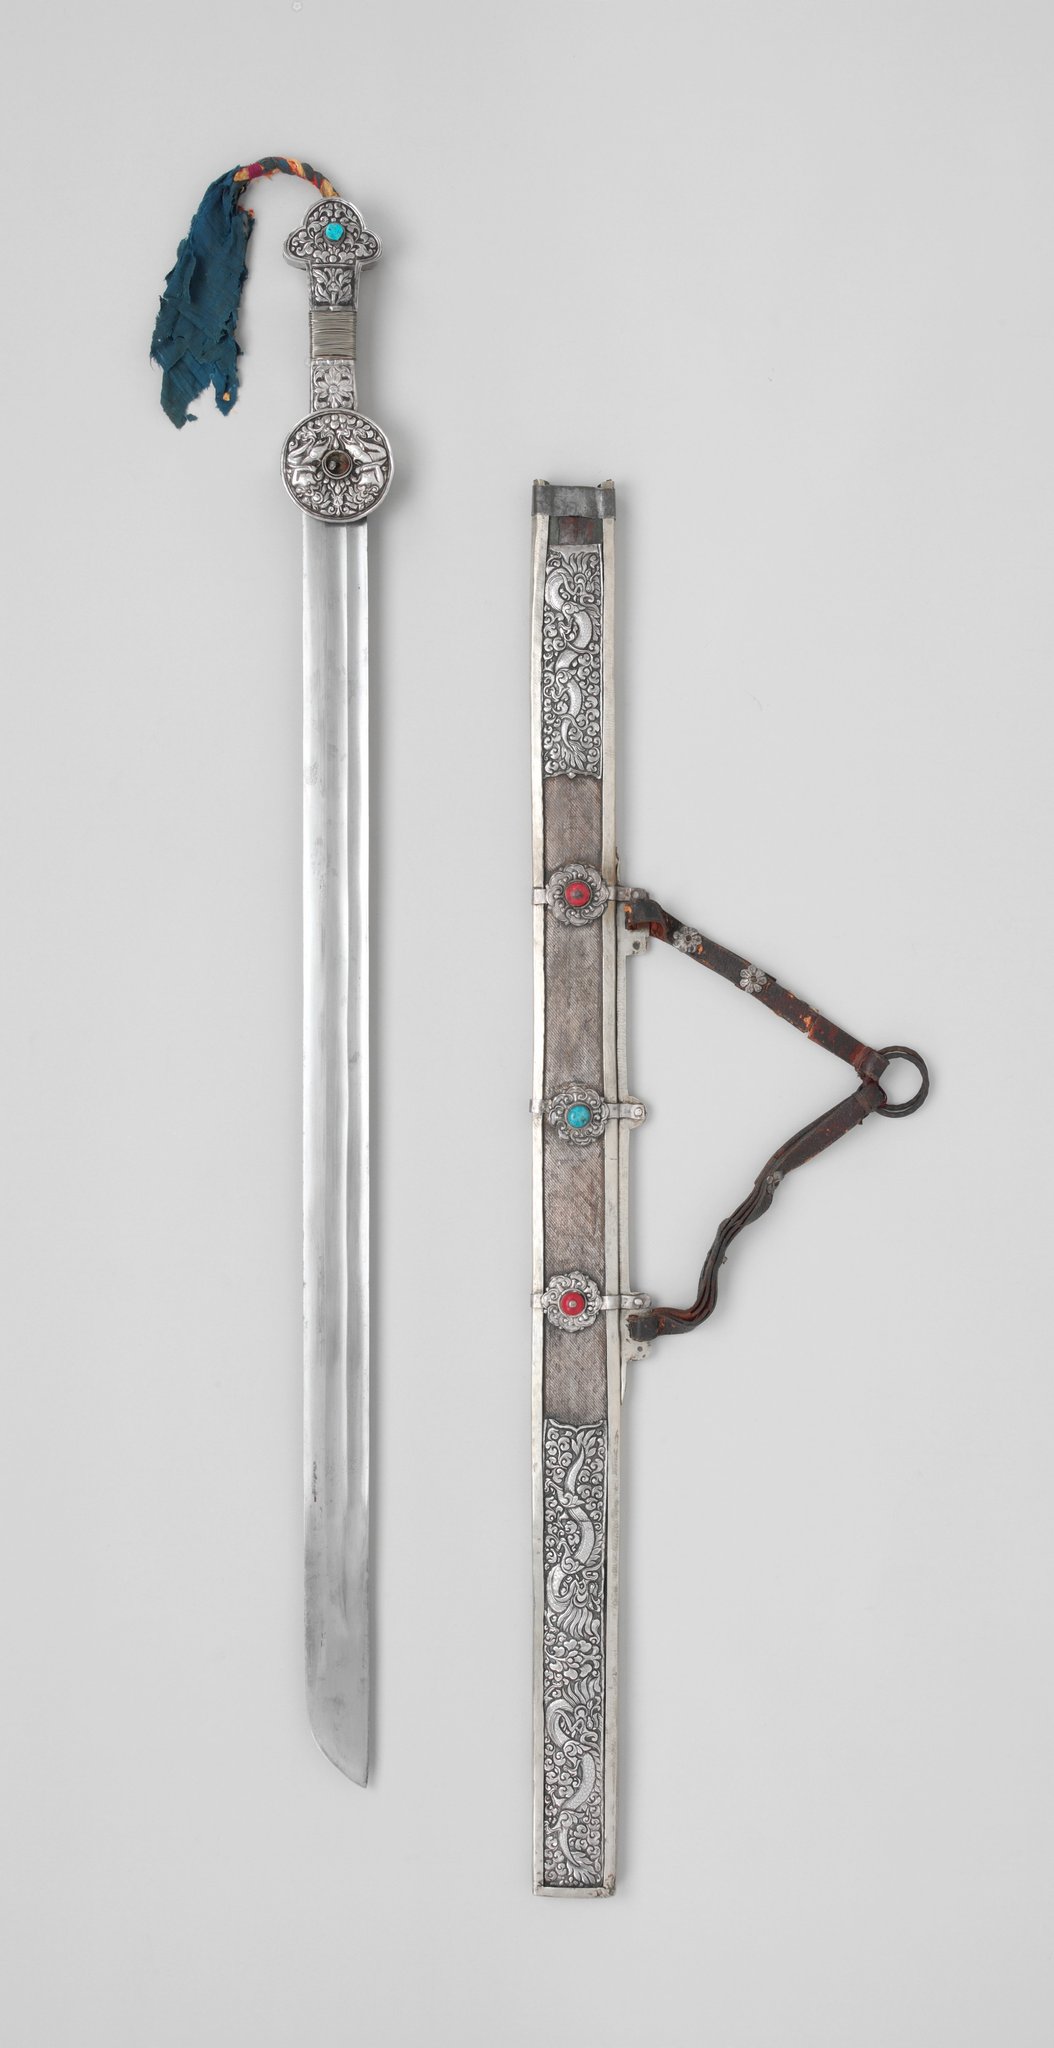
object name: sword with scabbard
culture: tibetan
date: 1701-1900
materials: coral, iron, leather, silver, textile, wood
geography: tibet